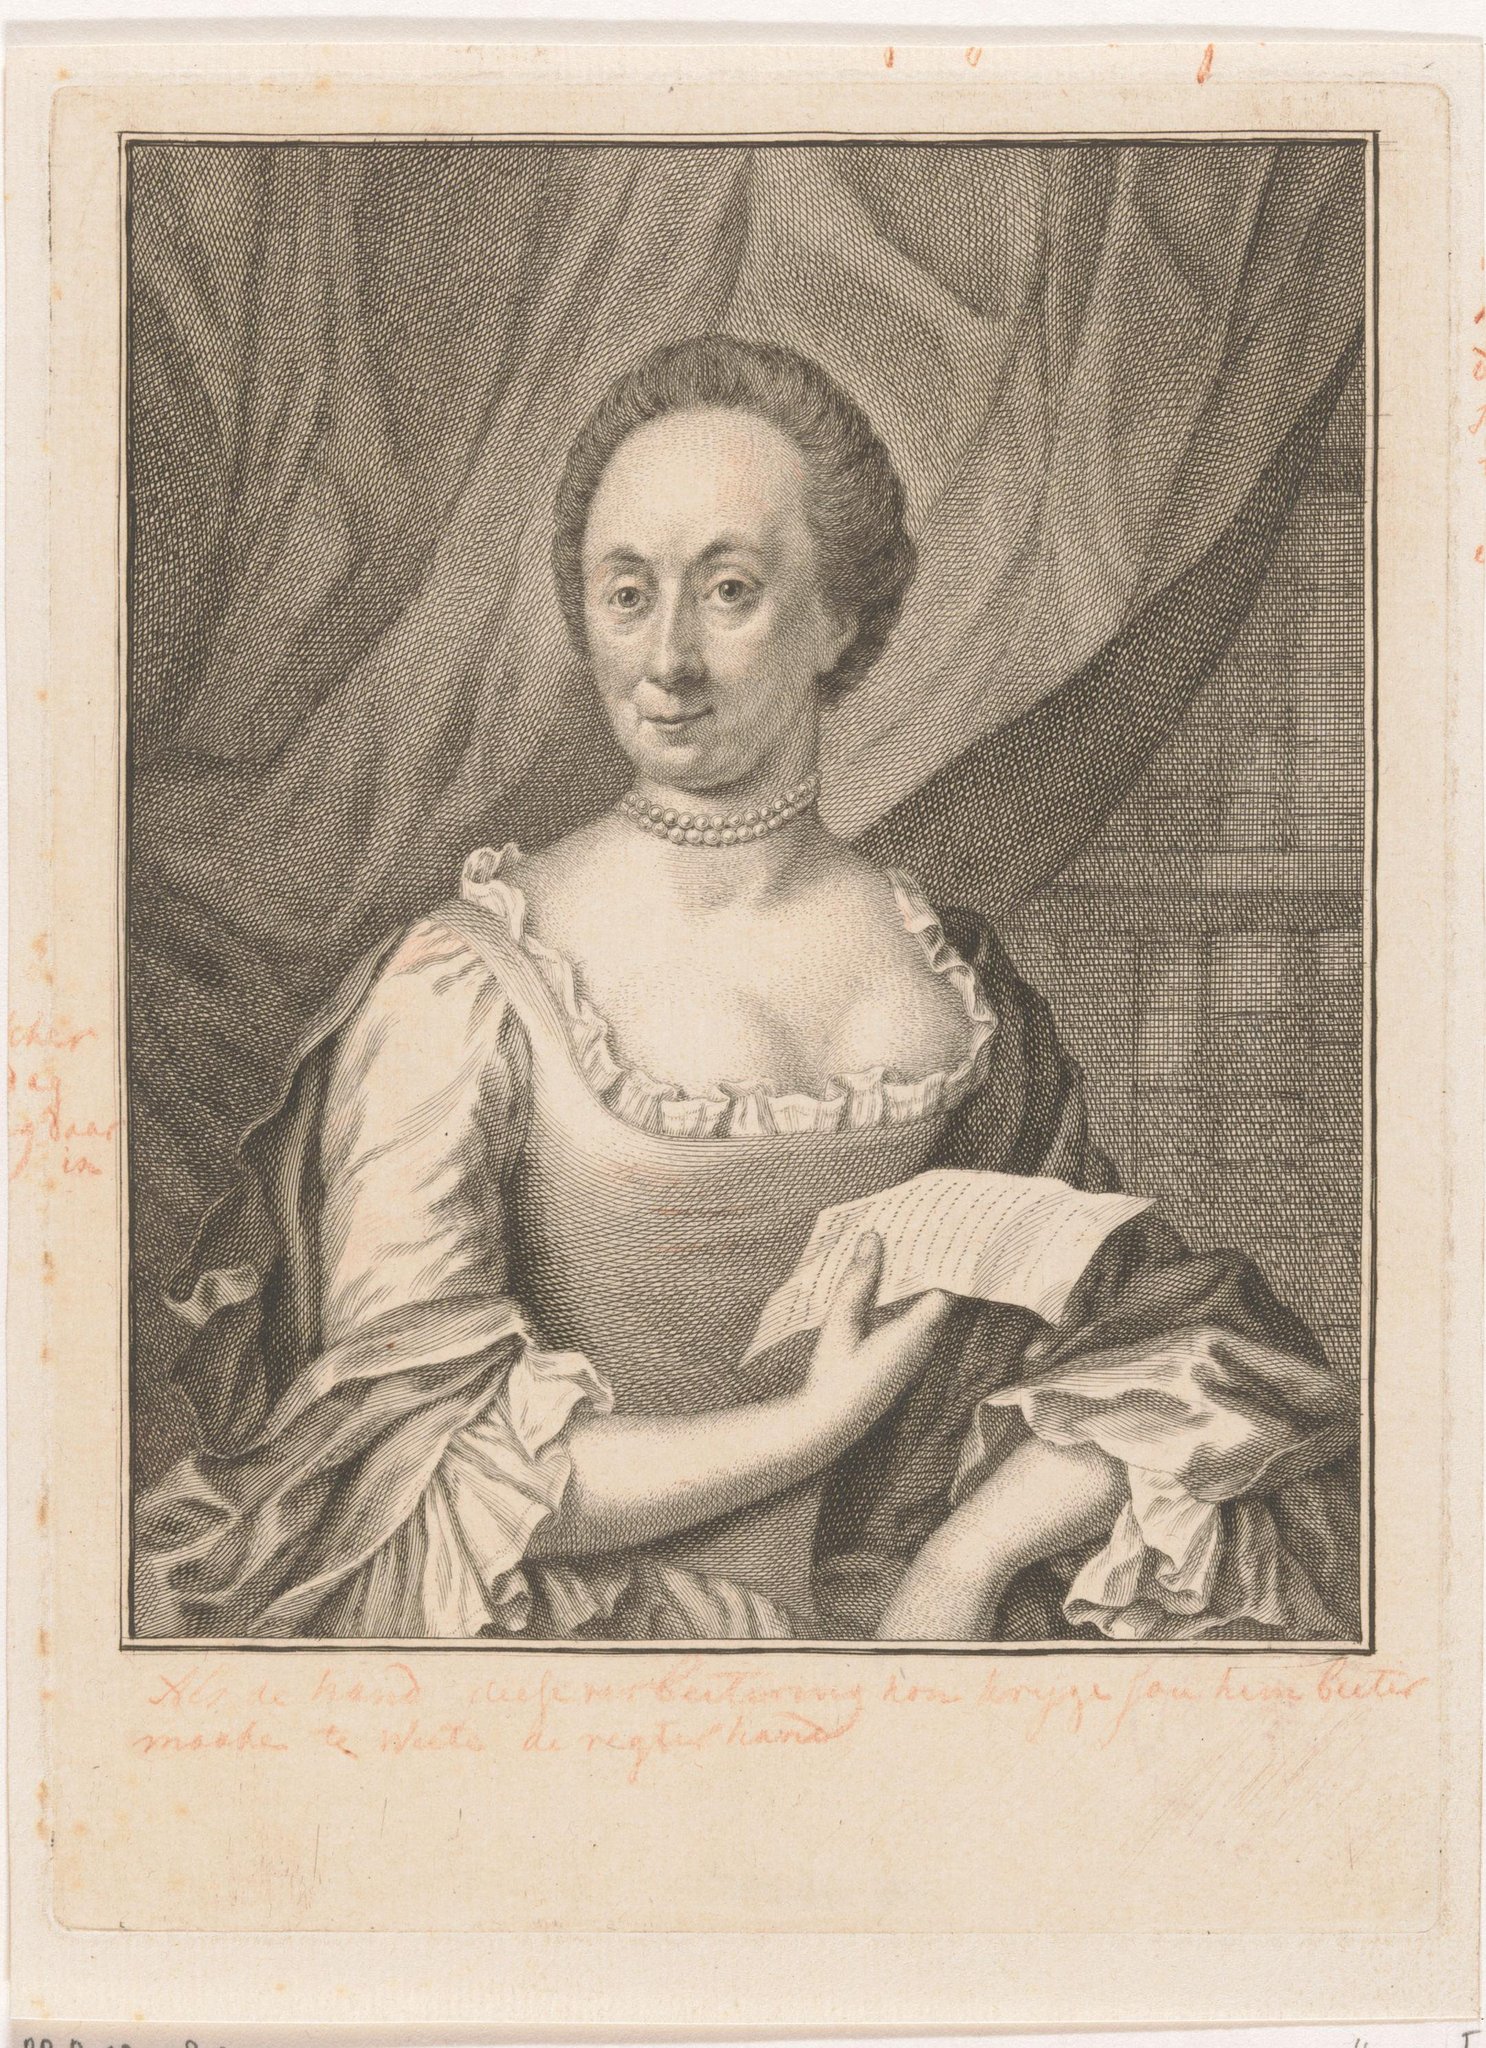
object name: print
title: Portret van Sara Maria van der Wilp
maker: jacob houbraken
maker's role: draughtsman, print maker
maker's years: 1698-1780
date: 1771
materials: paper, pencil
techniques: engraving, etching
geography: amsterdam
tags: sara maria van der wilp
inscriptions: collector's mark: Lugt 240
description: Portret van de dichteres Sara Maria van der Wilp.